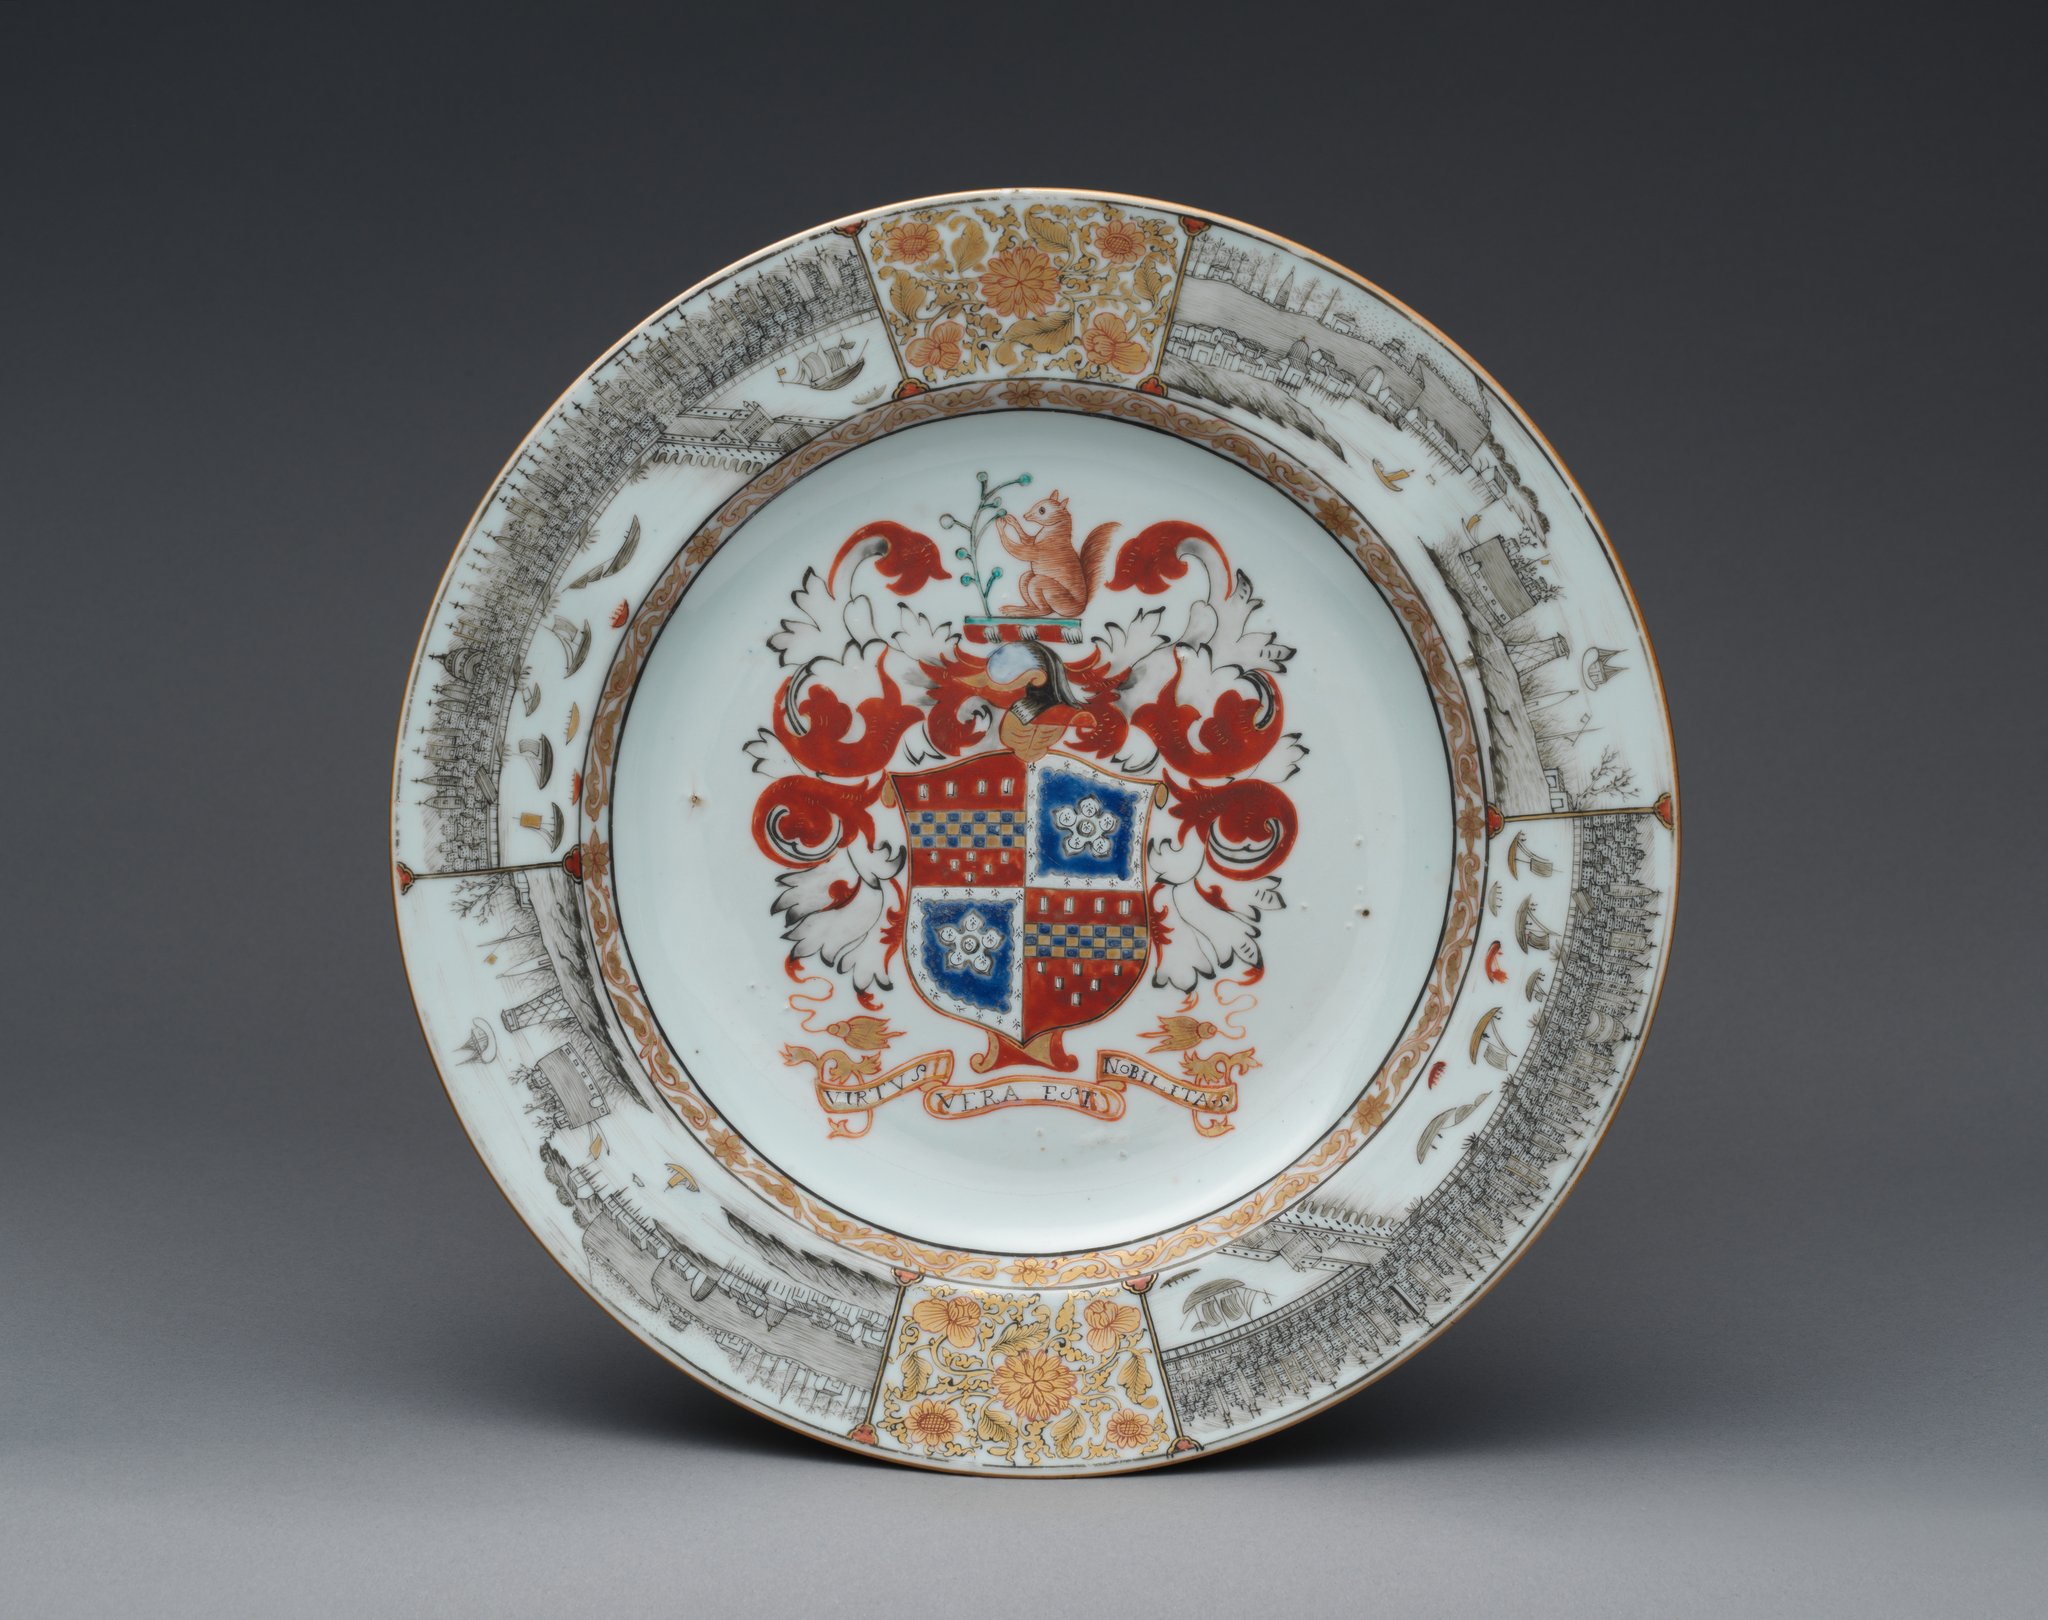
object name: plate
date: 1730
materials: hard paste porcelain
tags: rabbits,flowers,coat of arms